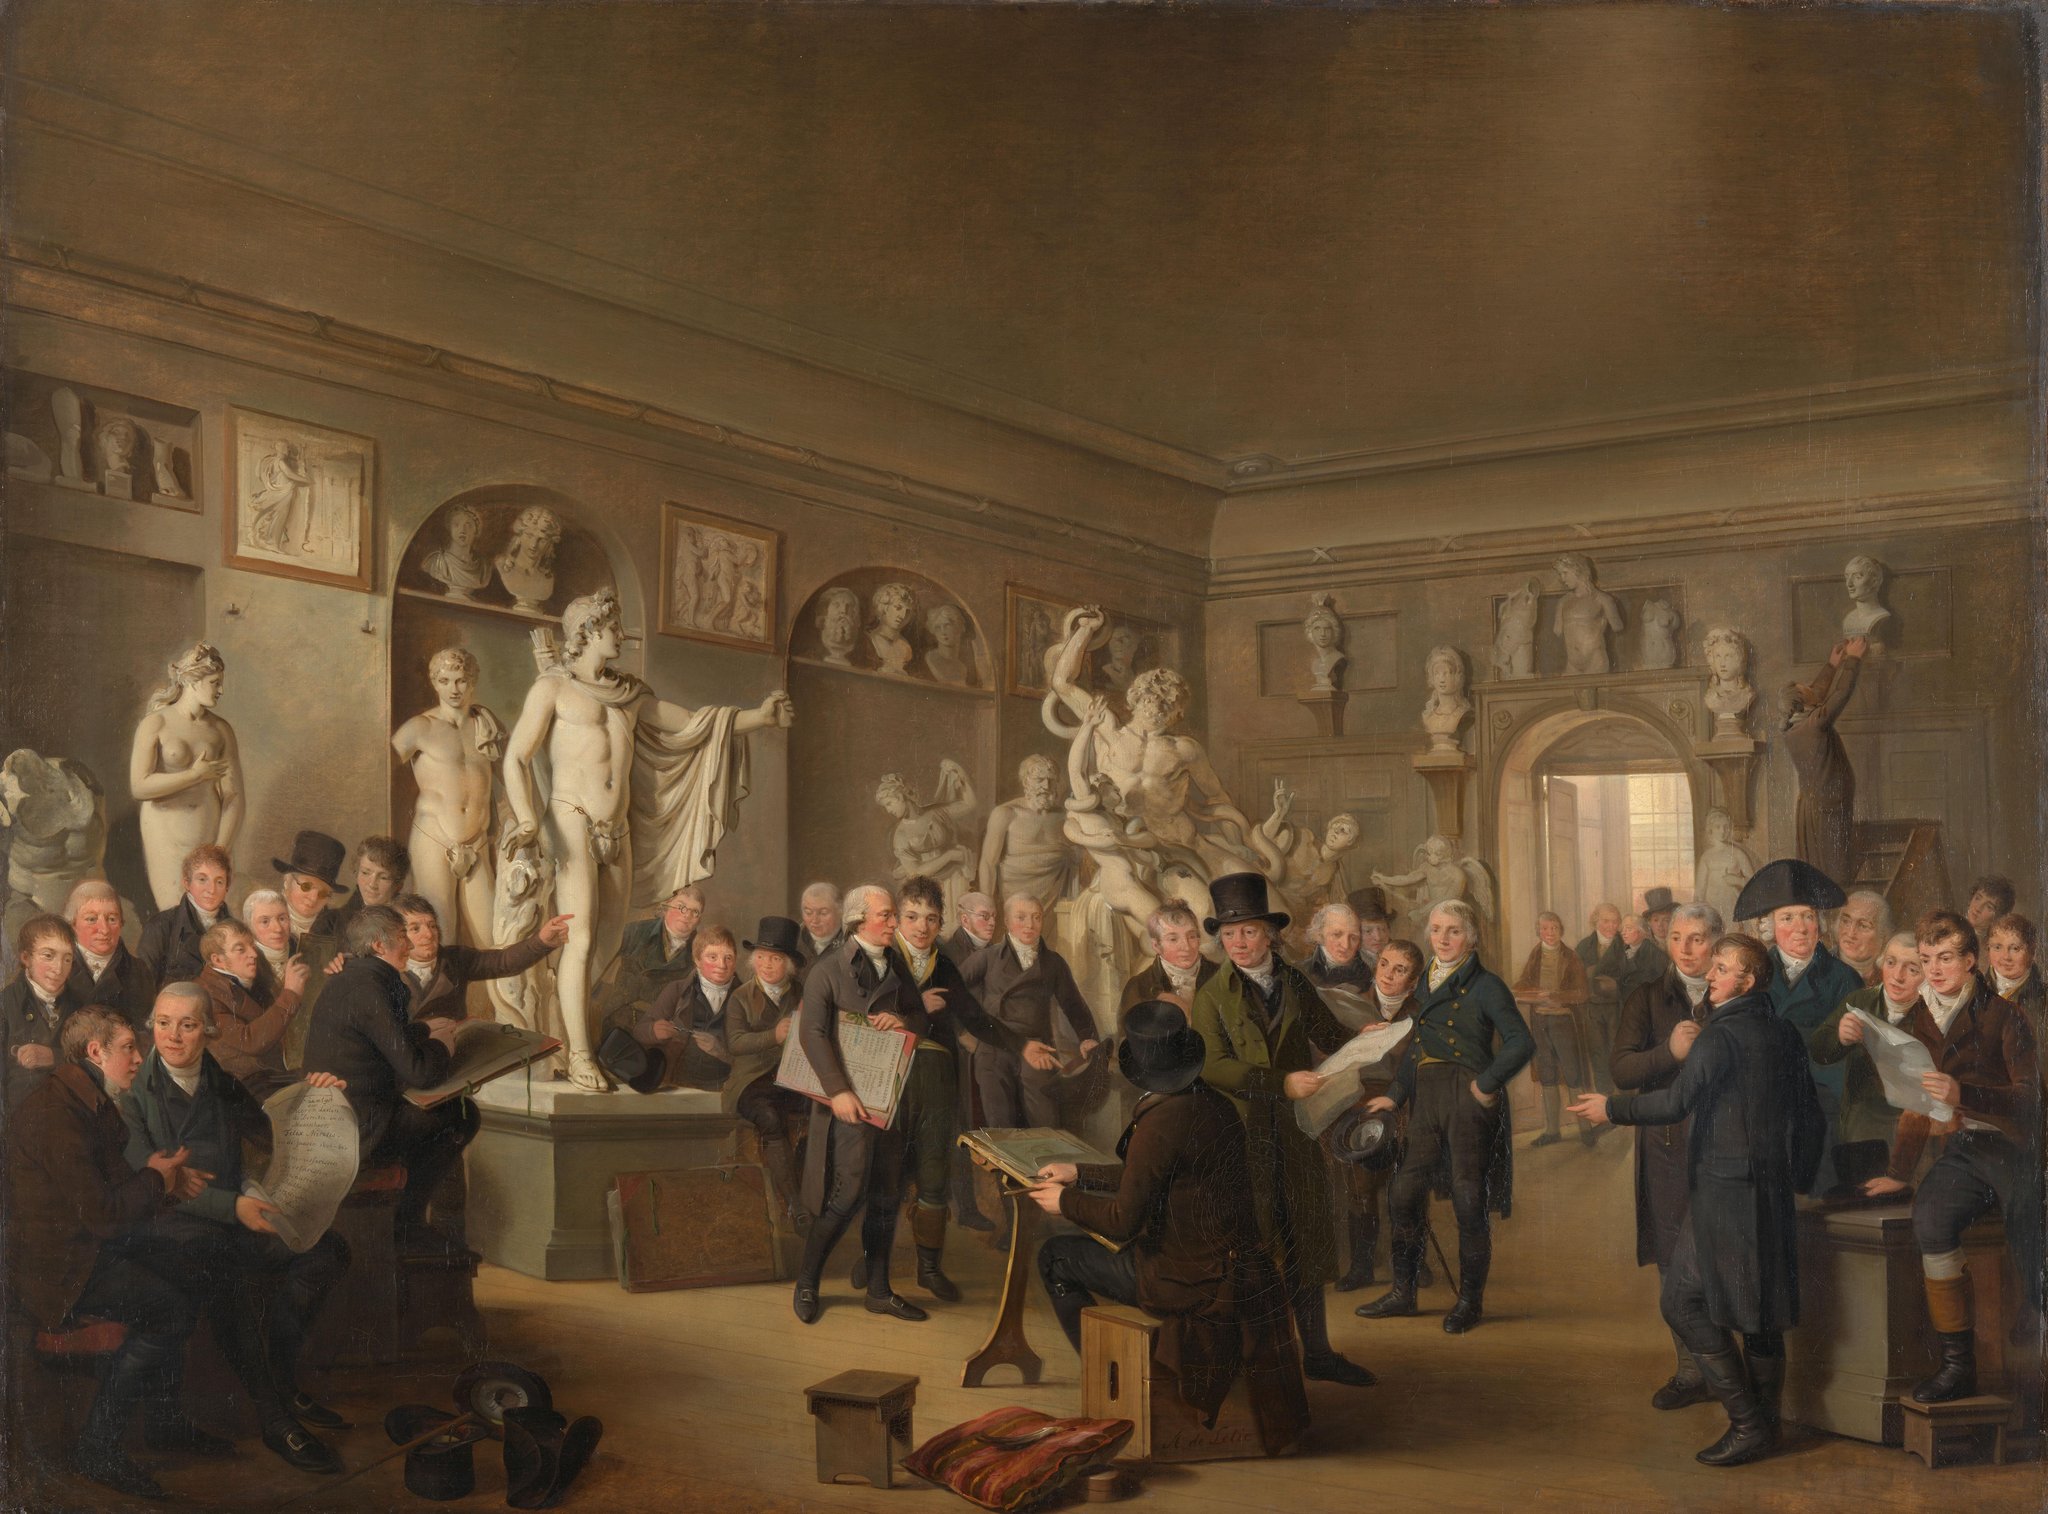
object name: painting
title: The Sculpture Gallery of the Felix Meritis Society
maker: adriaan de lelie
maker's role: draughtsman, painter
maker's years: 1755-1820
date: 1806-1809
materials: canvas, oil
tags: gallery of sculptures, amsterdam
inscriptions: signature: ‘A. de Lelie’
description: In the sculpture gallery of the Felix Meritis Society, plaster casts of sculptures from Roman museums and the Musée Napoléon in Paris were exhibited against pale blue walls. De Lelie, a member of the society, portrayed himself from the back amidst the commis-sioners and directors of the scoiety’s departments.